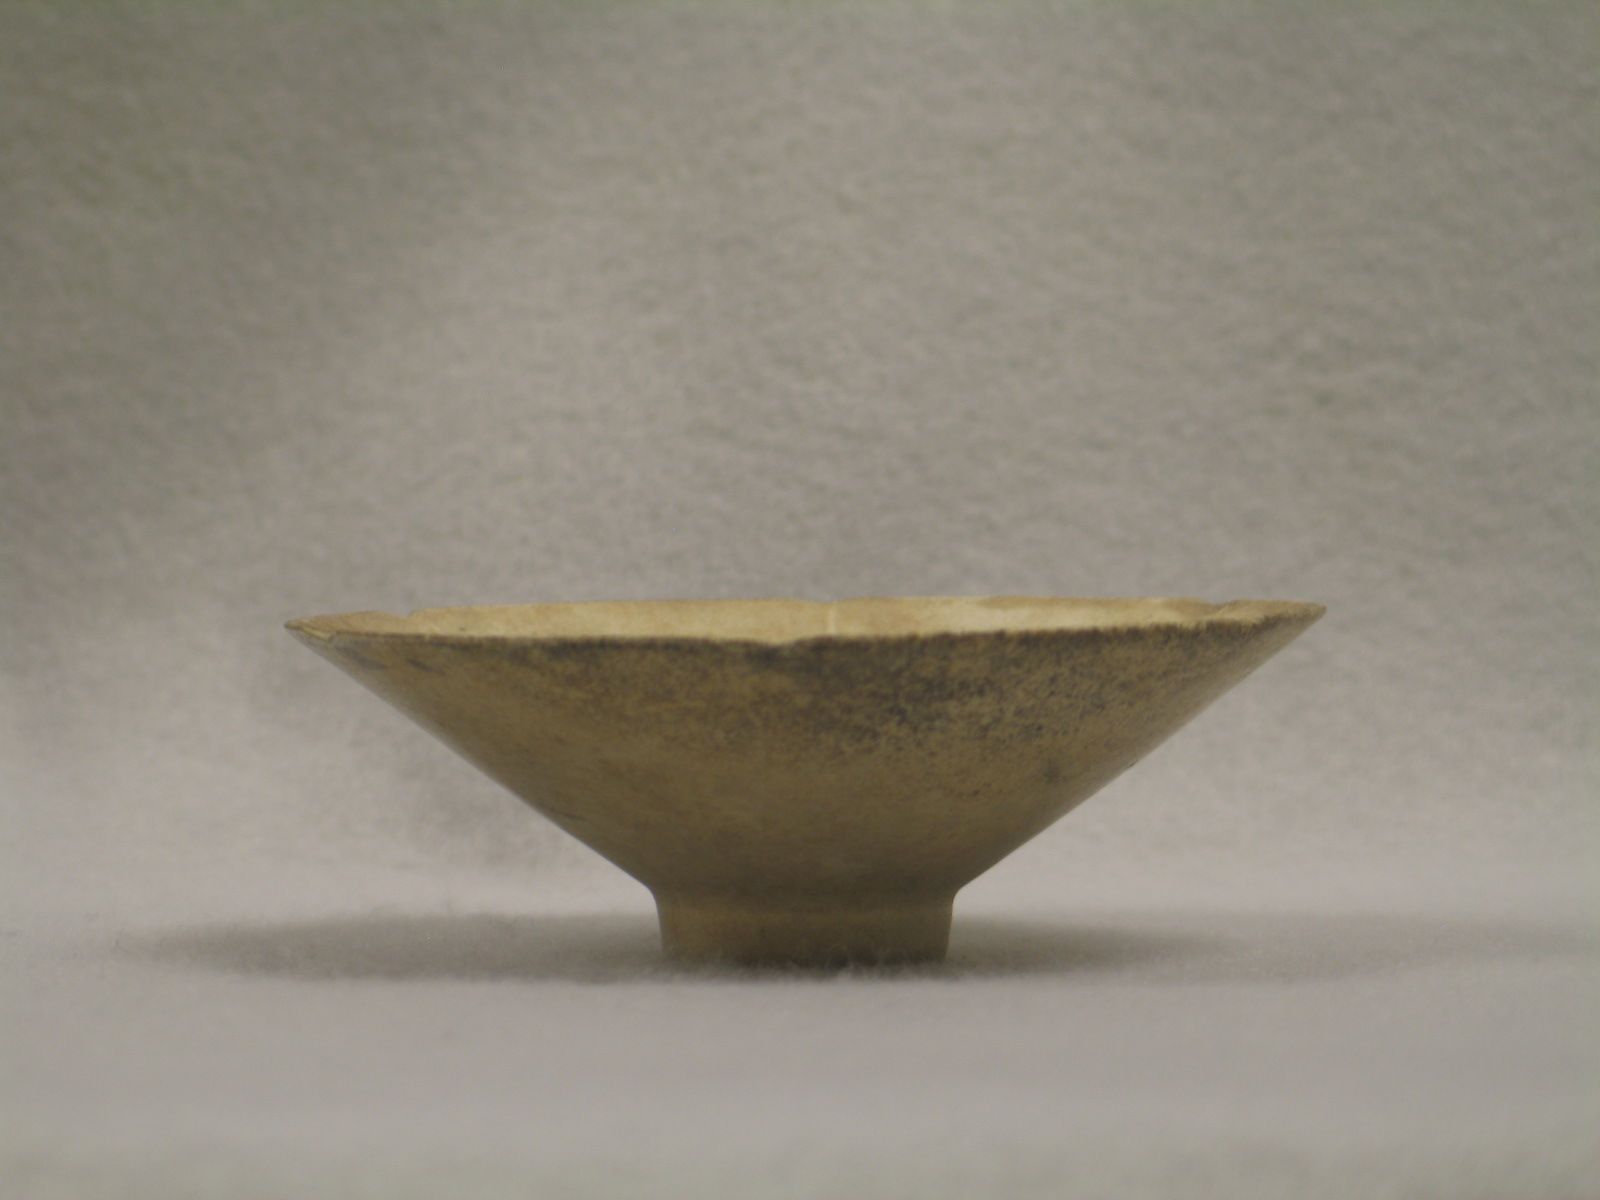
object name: bowl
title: Lobed bowl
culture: chinese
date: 1001-1200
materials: glaze, porcelain